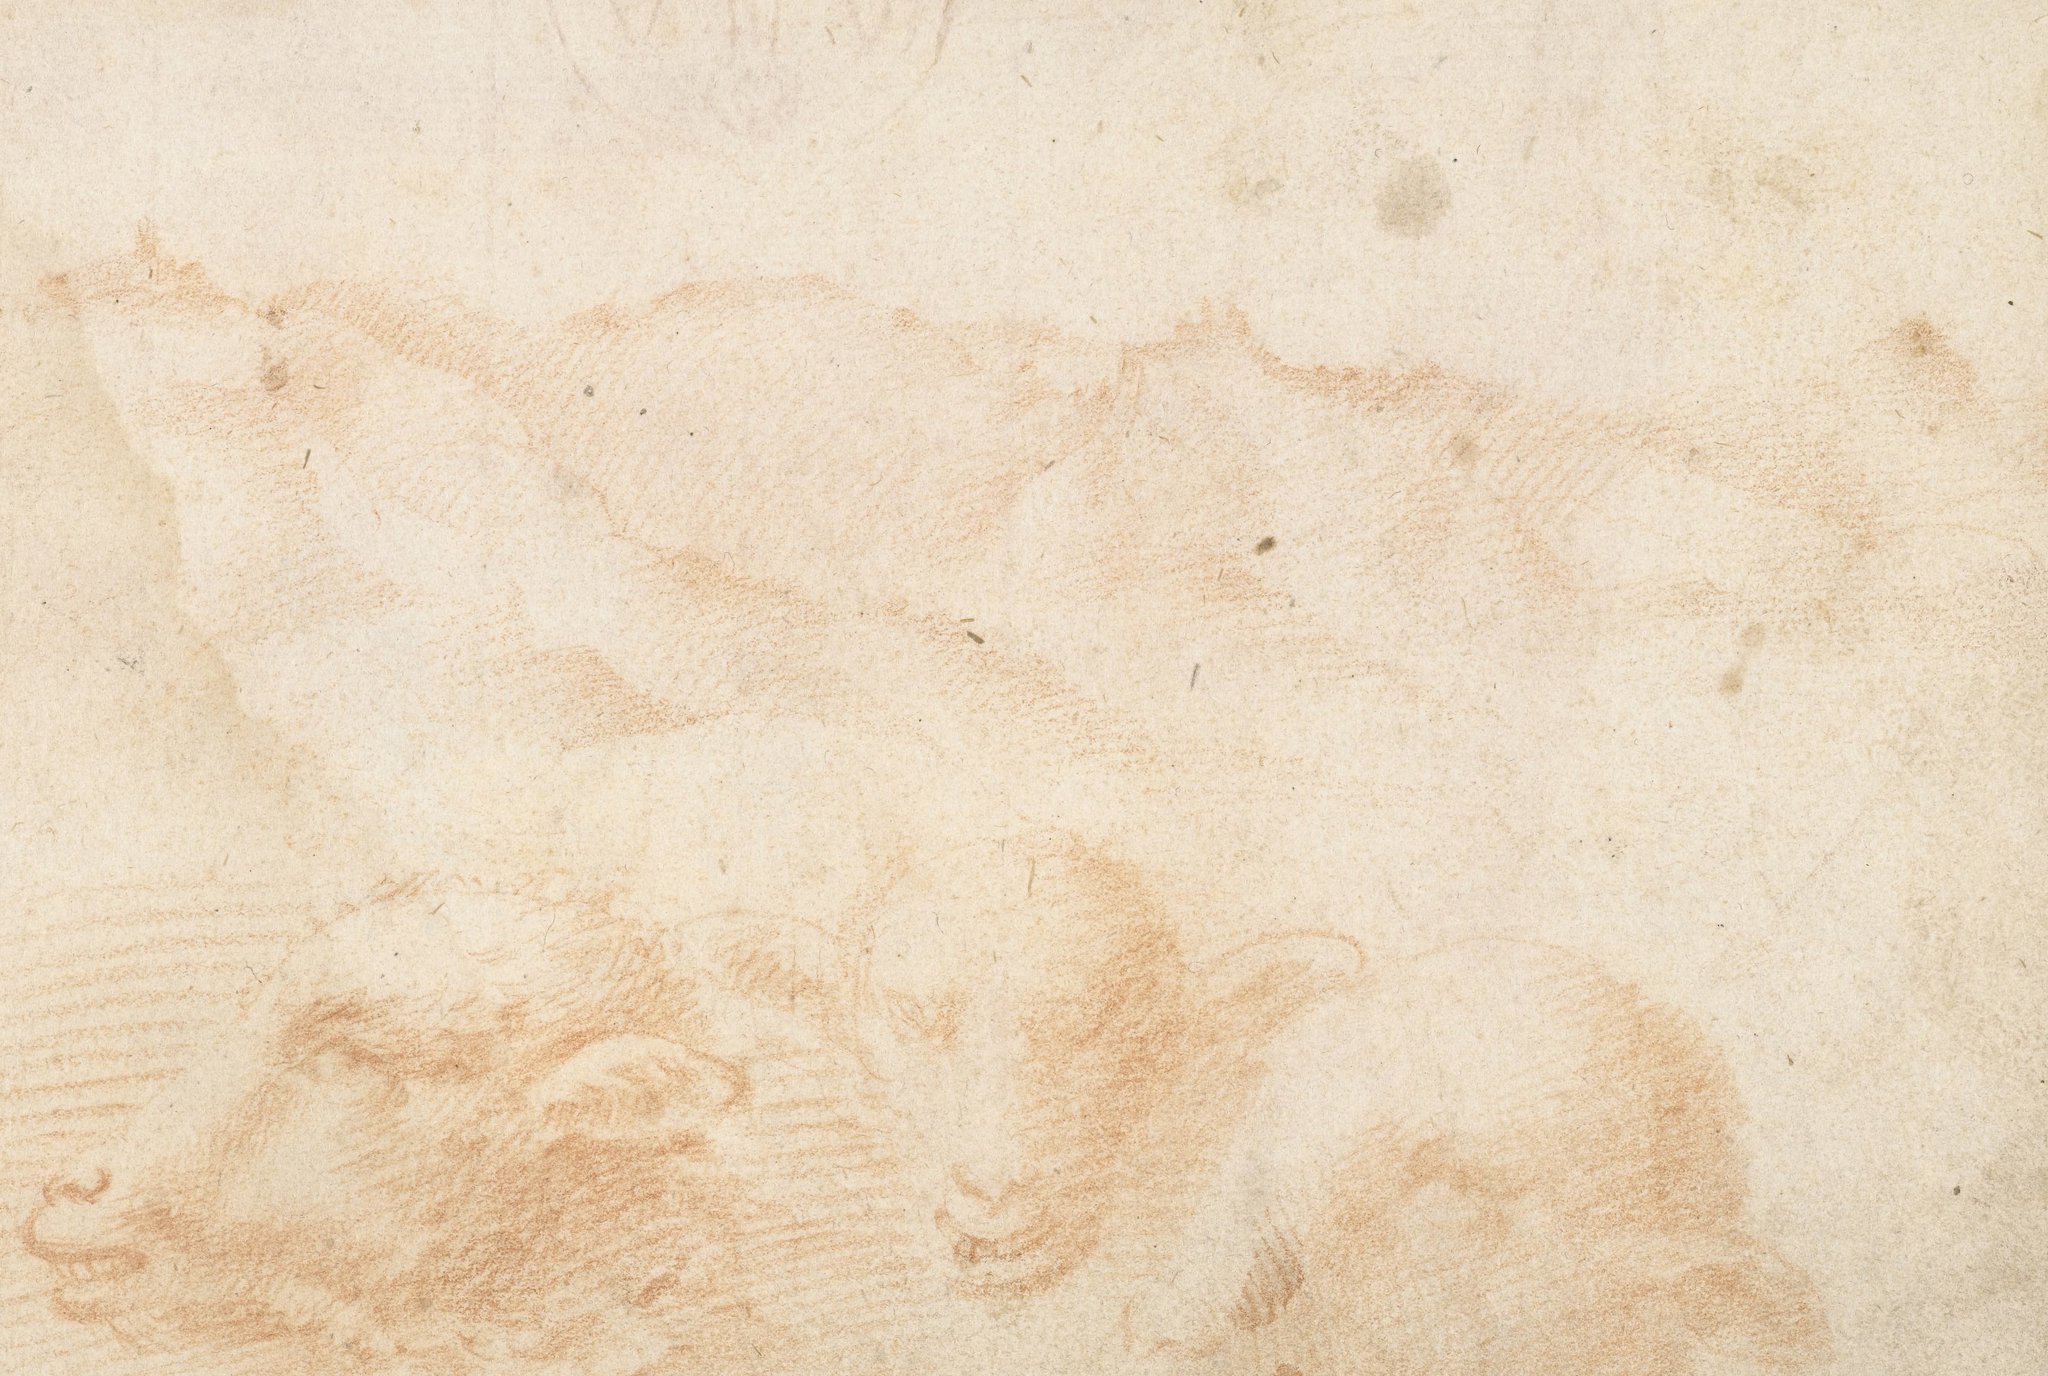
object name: drawing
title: Heuvellandschap met drie schaapskoppen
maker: domenico beccafumi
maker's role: draughtsman, painter, print maker, sculptor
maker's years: 1486-1551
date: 1500-1551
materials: chalk, paper